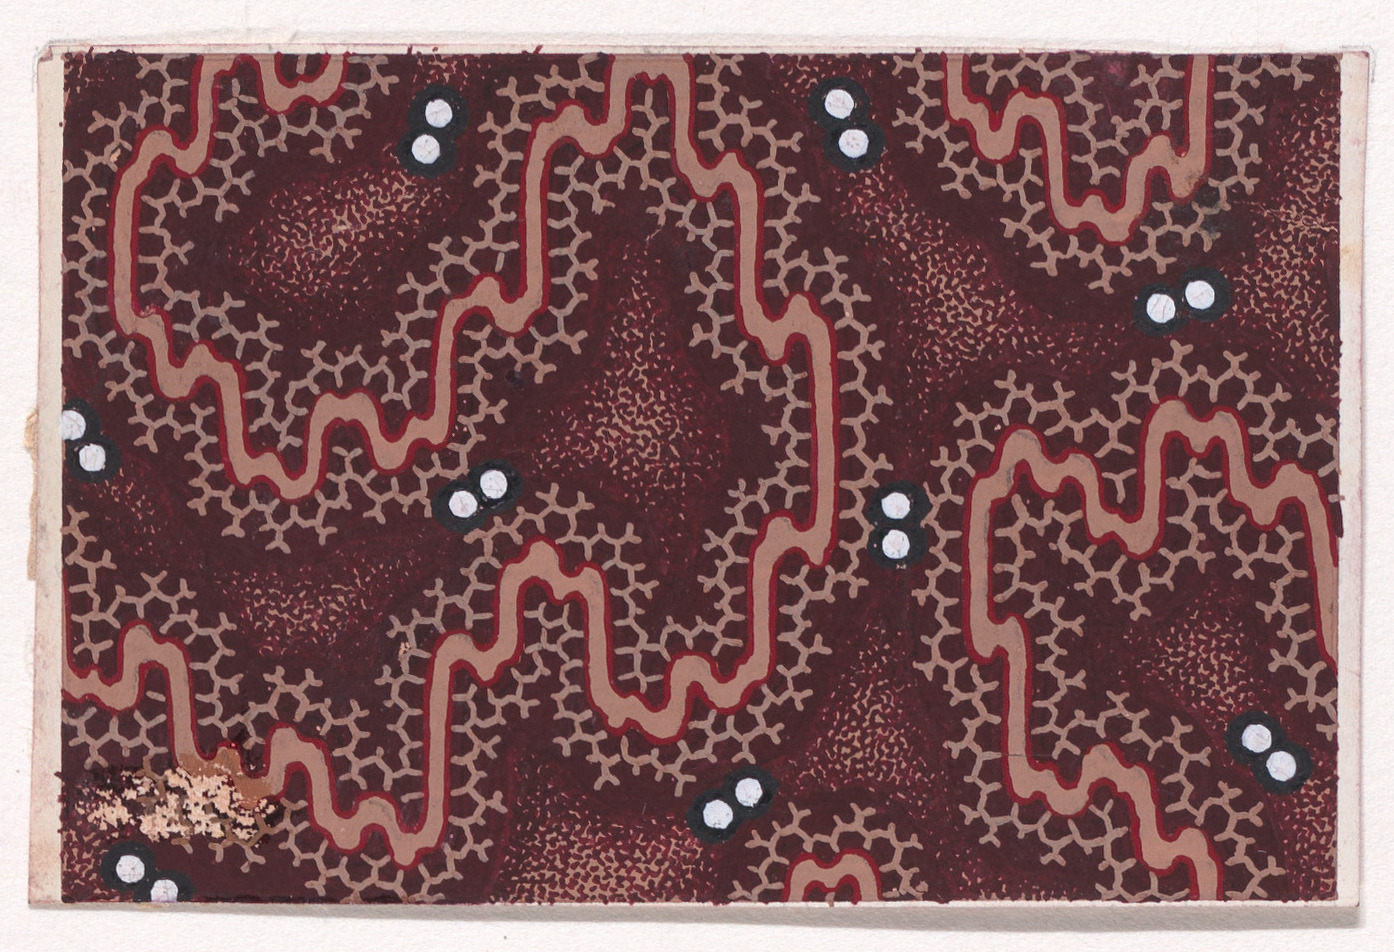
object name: drawing ornament architecture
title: Textile Design with an Undulating Ribbon with Honeycomb Pattern Offsetts and Pearls over a Stippled Background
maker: anonymous, alsatian, 19th century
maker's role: artist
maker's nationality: alsatian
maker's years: 1800-1900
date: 1840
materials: gouache